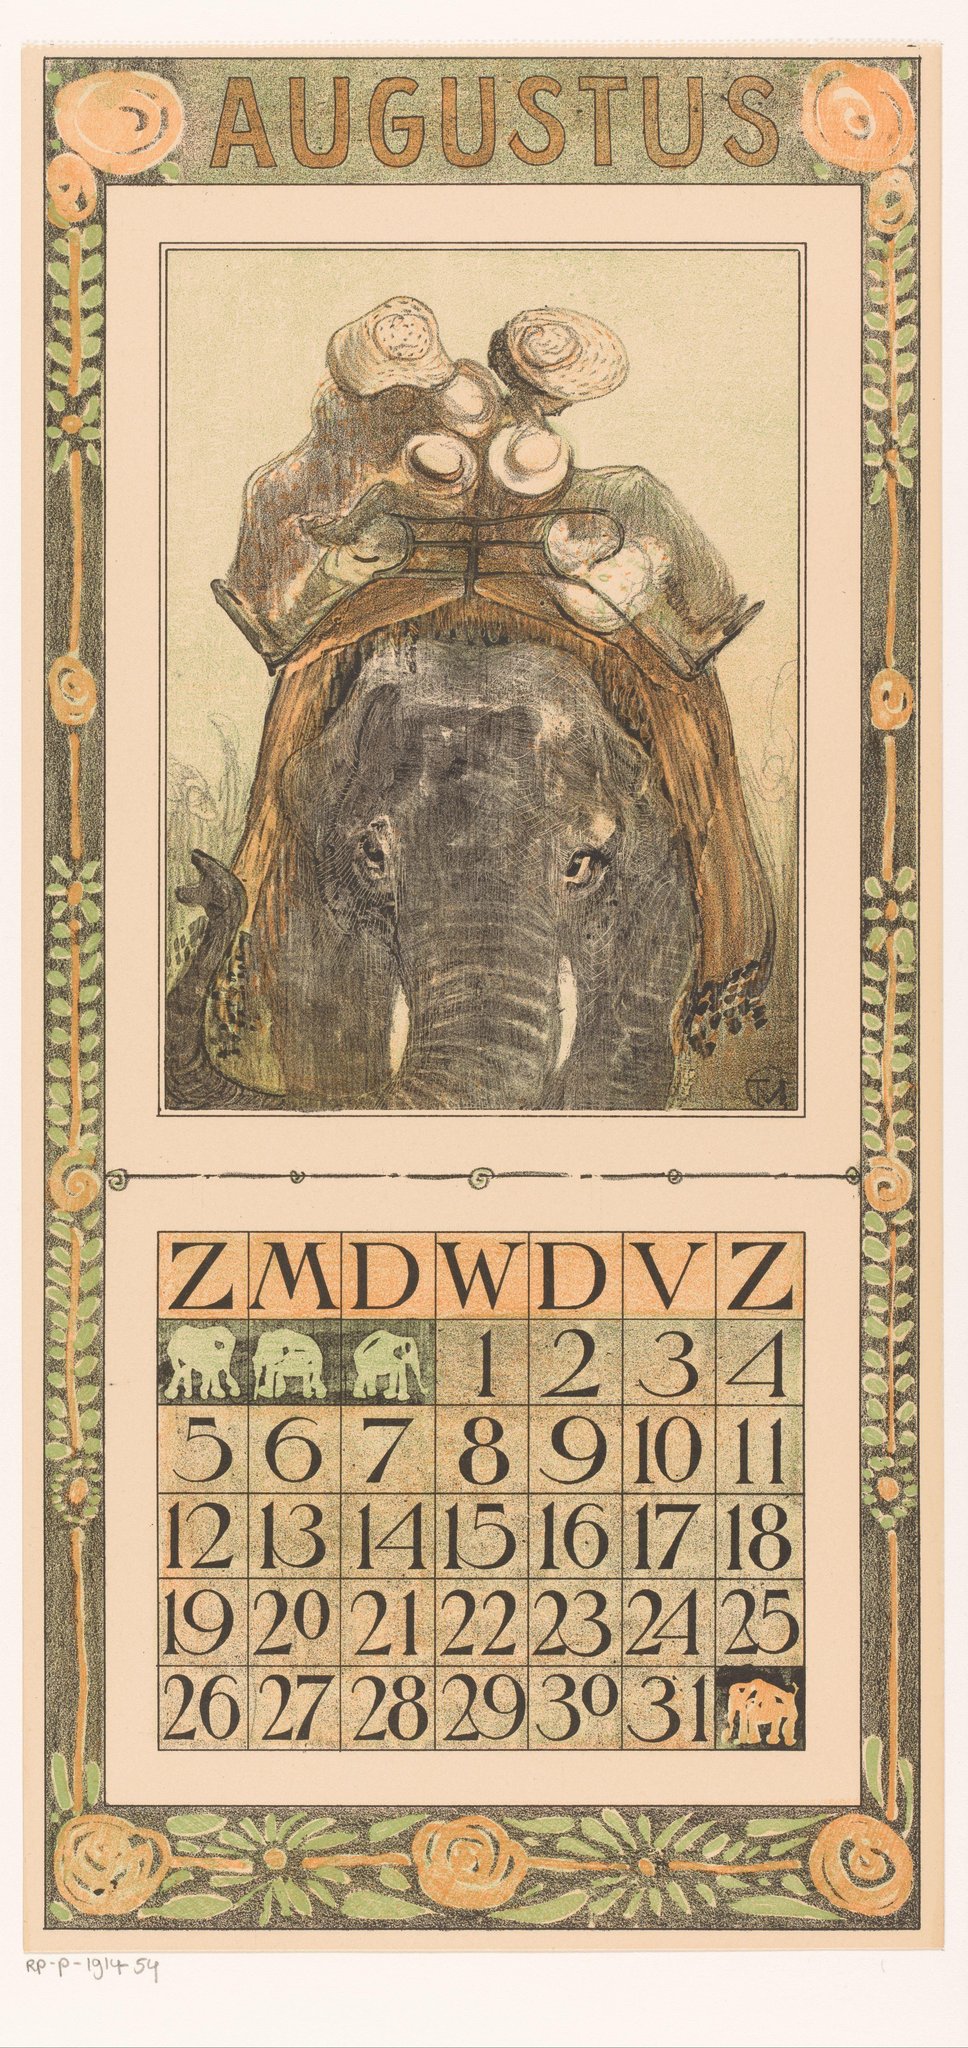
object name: calendar leaf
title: Kalenderblad augustus met olifant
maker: theo van hoytema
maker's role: draughtsman, painter, print maker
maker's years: 1863-1917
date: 1905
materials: paper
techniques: lithograph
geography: amsterdam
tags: trunked animals (with name) (+ animal riding), trunked animals: elephant, august ~ other concepts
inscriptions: collector's mark: Lugt 2228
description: De olifant heeft een groep kinderen op zijn rug. Bovenaan het blad een scheurlijn.